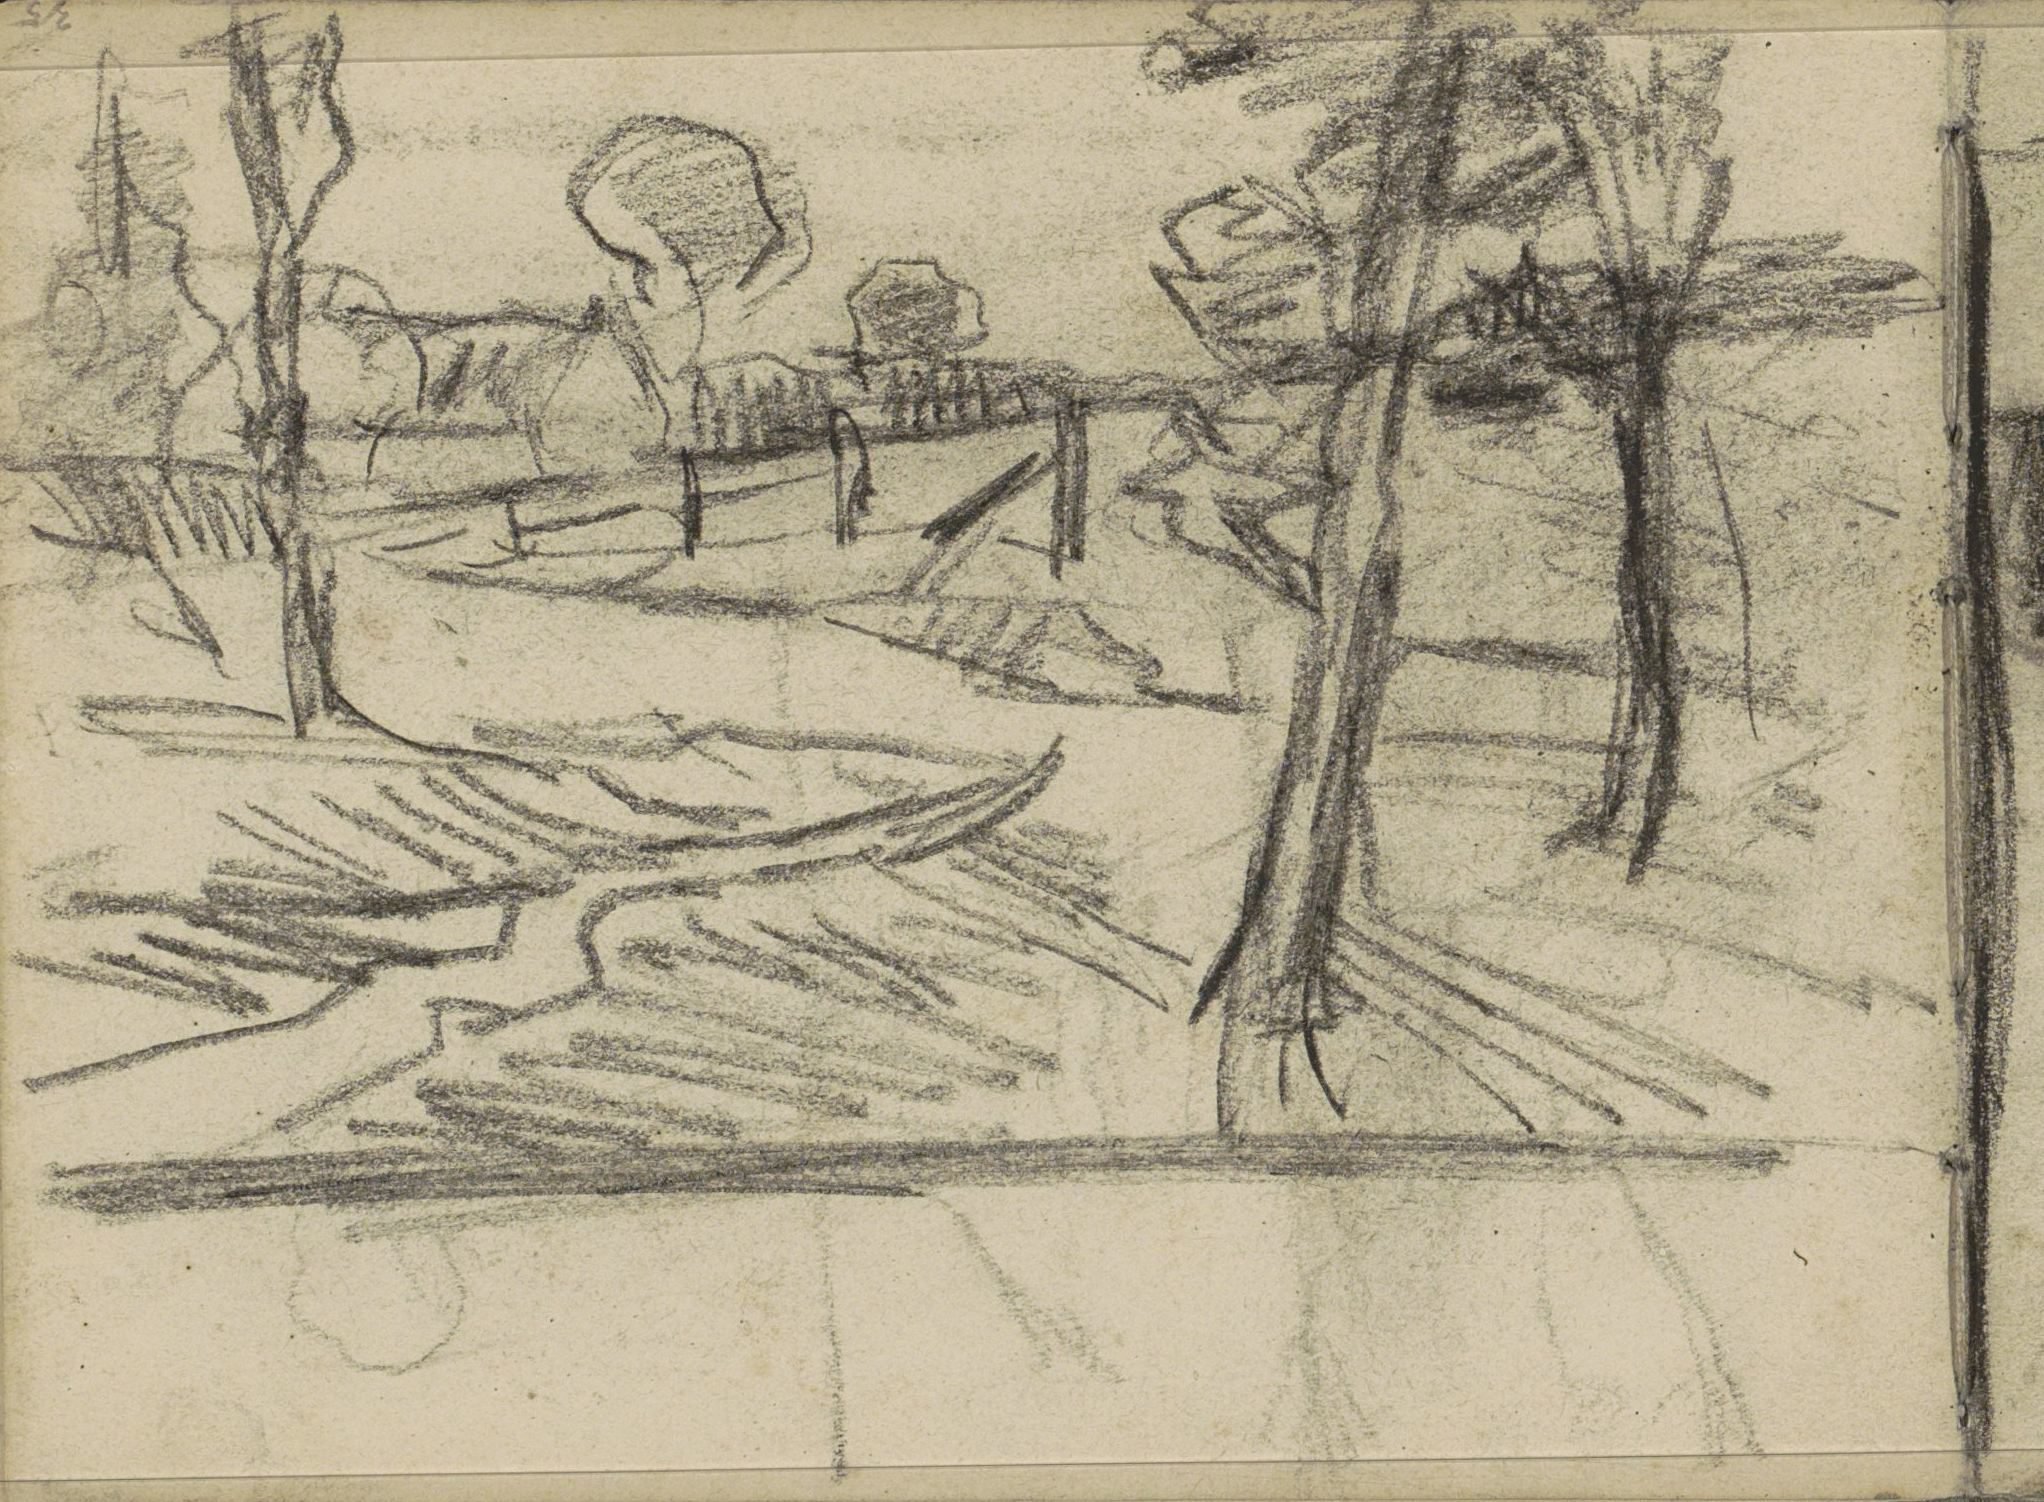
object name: sketchbook leaf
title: Landschap met bomen en een huis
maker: hermannus adrianus van oosterzee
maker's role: draughtsman, painter, print maker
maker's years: 1863-1933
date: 1893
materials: charcoal, paper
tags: farm or solitary house in landscape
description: Blad 12 verso uit een schetsboek met 23 bladen.